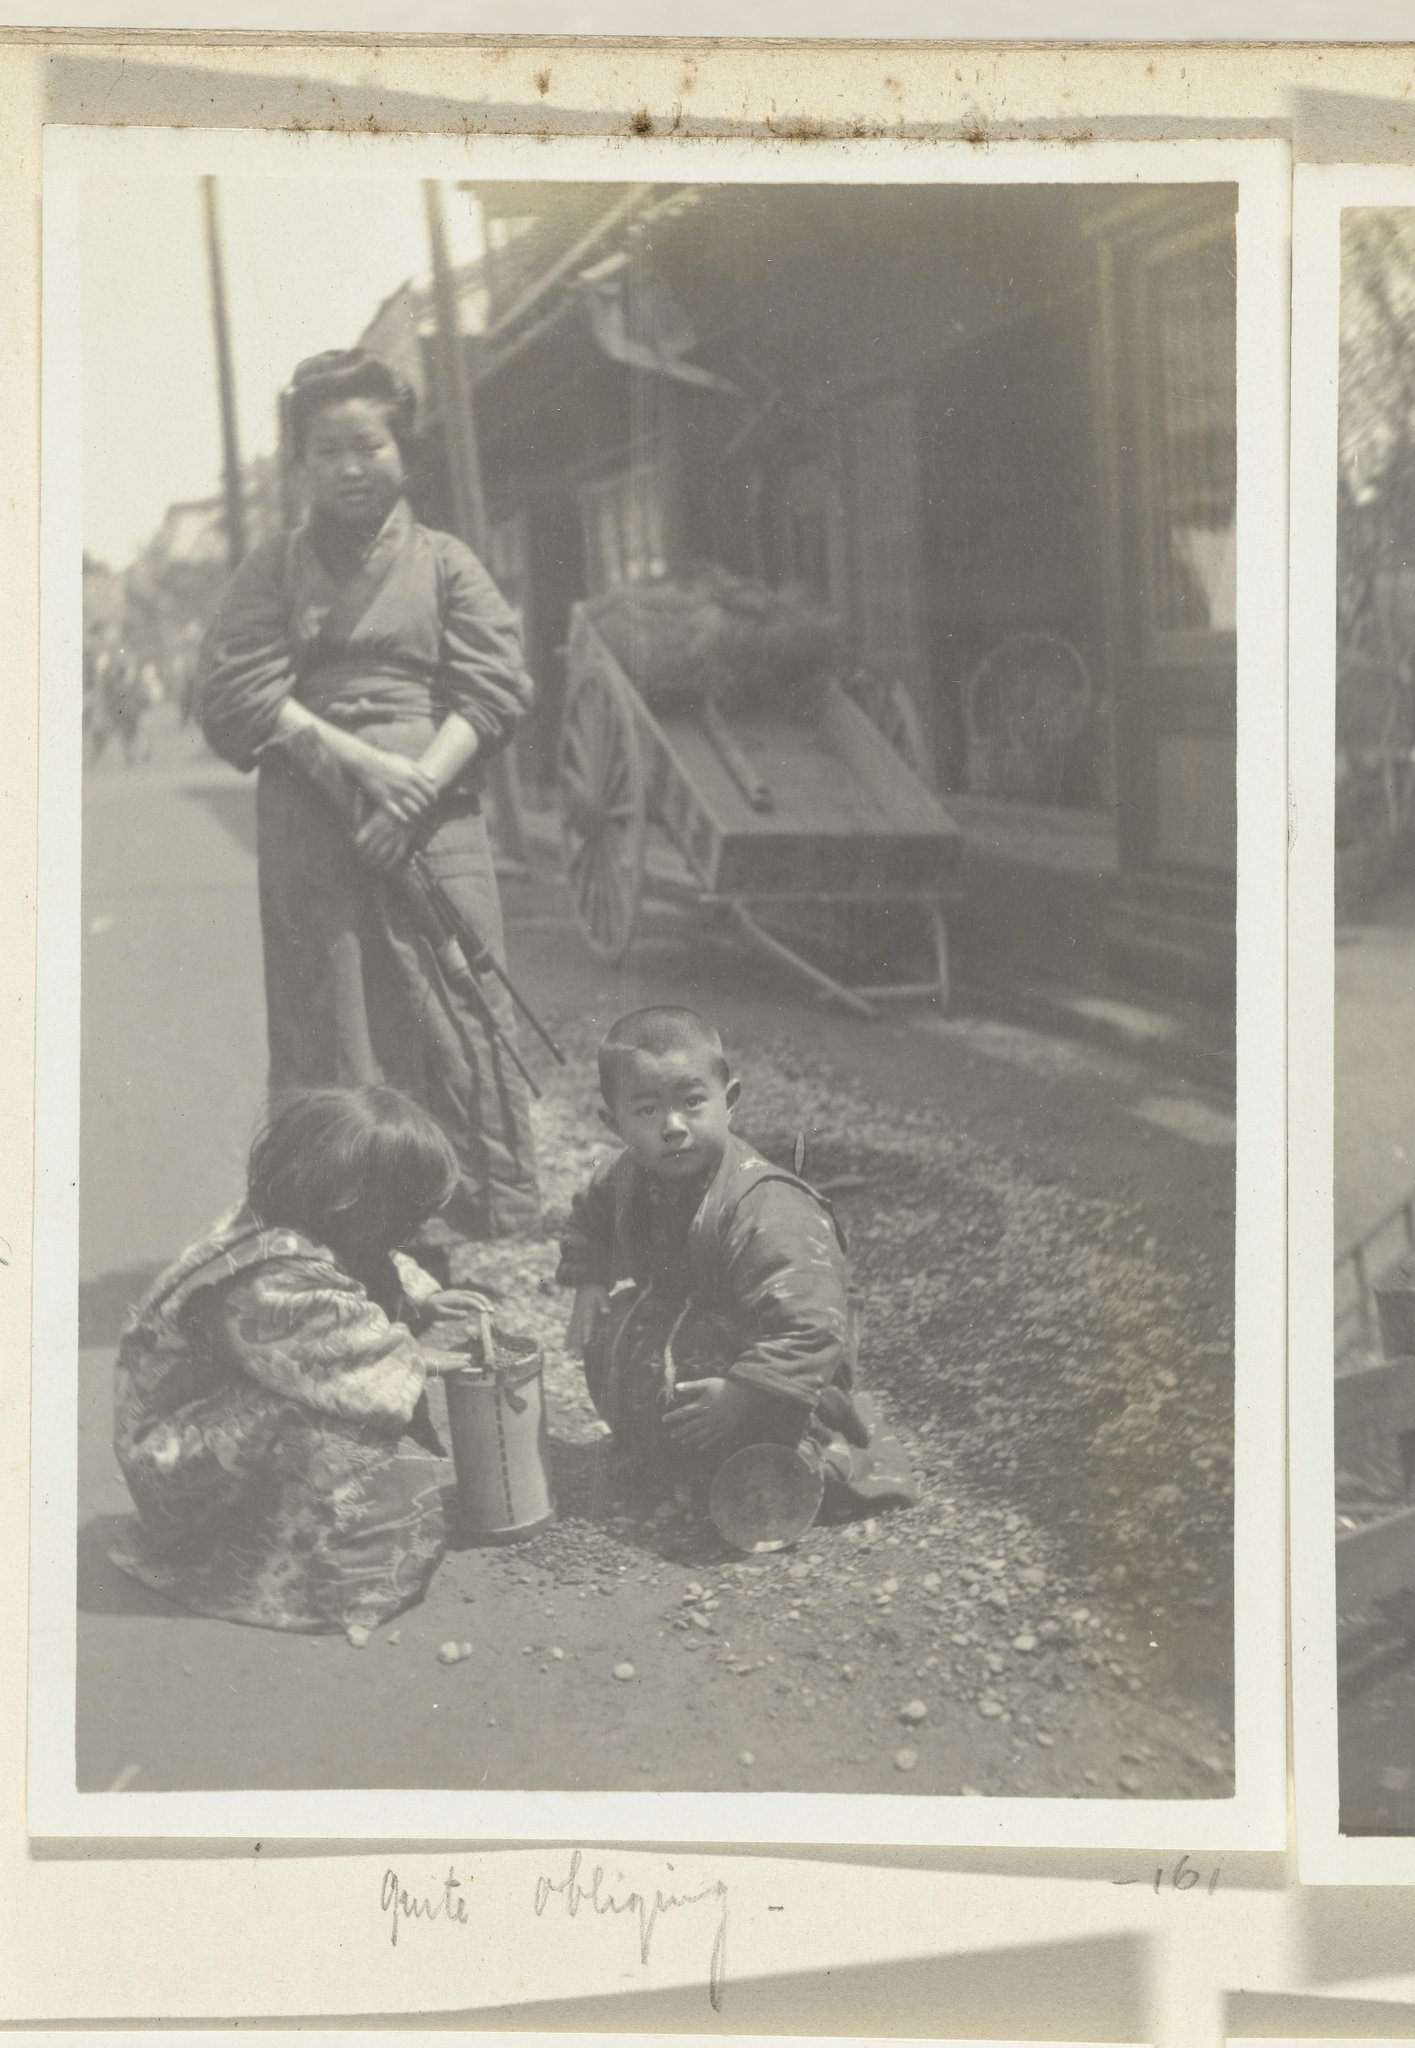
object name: photograph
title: Quite obliging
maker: geldolph adriaan kessler (dolph)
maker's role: fotograaf, industrieel, voetballer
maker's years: 1884-1945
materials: cardboard, photographic support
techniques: gelatin silver print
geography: tokyo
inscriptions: title: ‘quite obliging’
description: Japanse kinderen met hun moeder op straat in Tokyo. Onderdeel van het fotoalbum van Dolph Kessler met opnamen die hij maakte tijdens zijn verblijf in Engeland en op een wereldreis die hij als secretaris van Henri Deterding (directeur Koninklijke Olie) ondernam naar Nederlands-Indië, Japan, China en de Verenigde Staten, tussen 1906 en 1908.